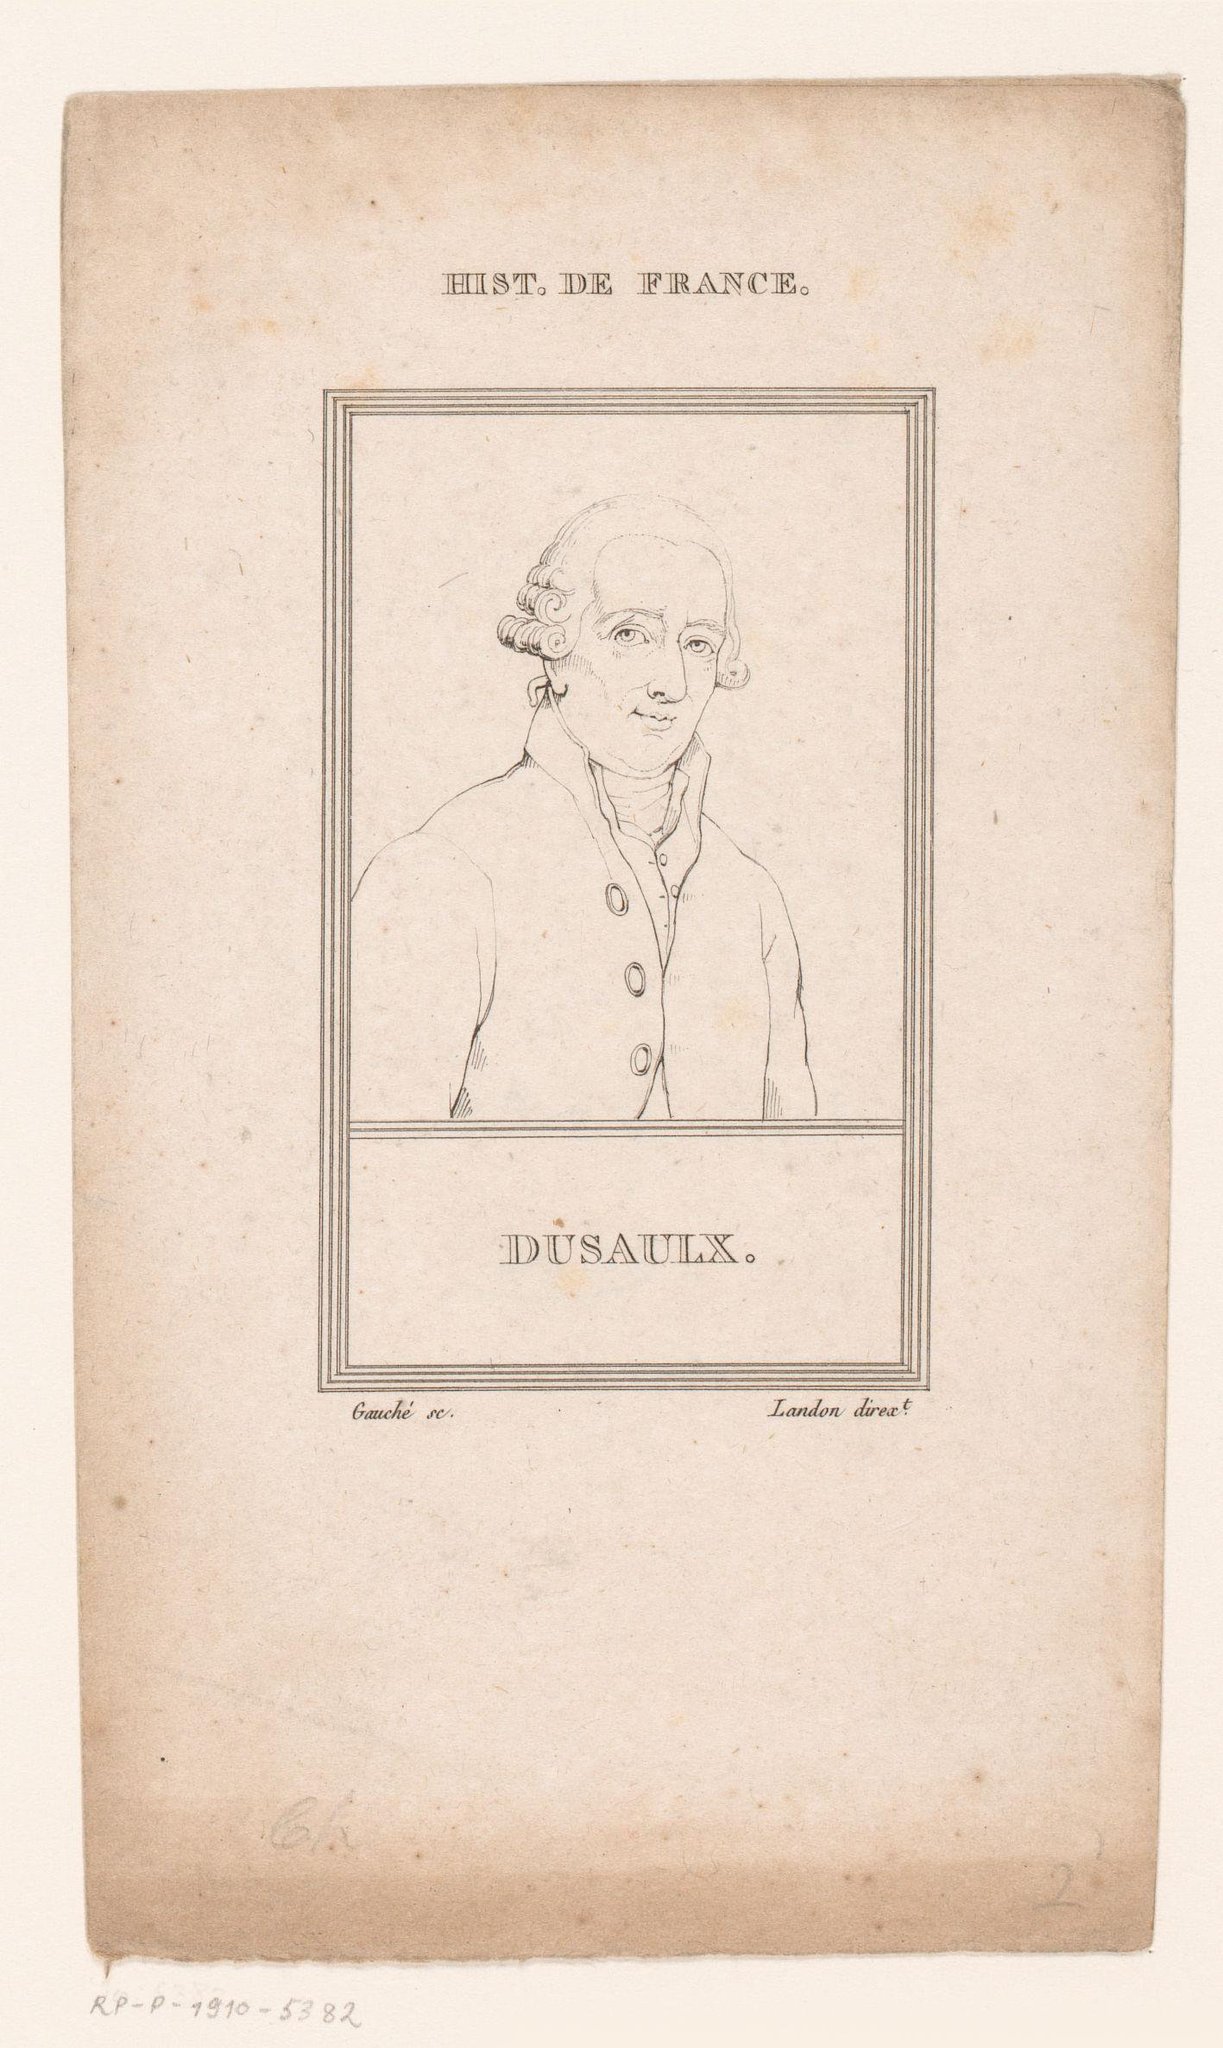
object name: print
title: Portret van Jean Dussaulx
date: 1770-1804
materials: paper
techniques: etching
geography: france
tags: paris, politician, historical persons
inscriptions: collector's mark: Lugt 2228